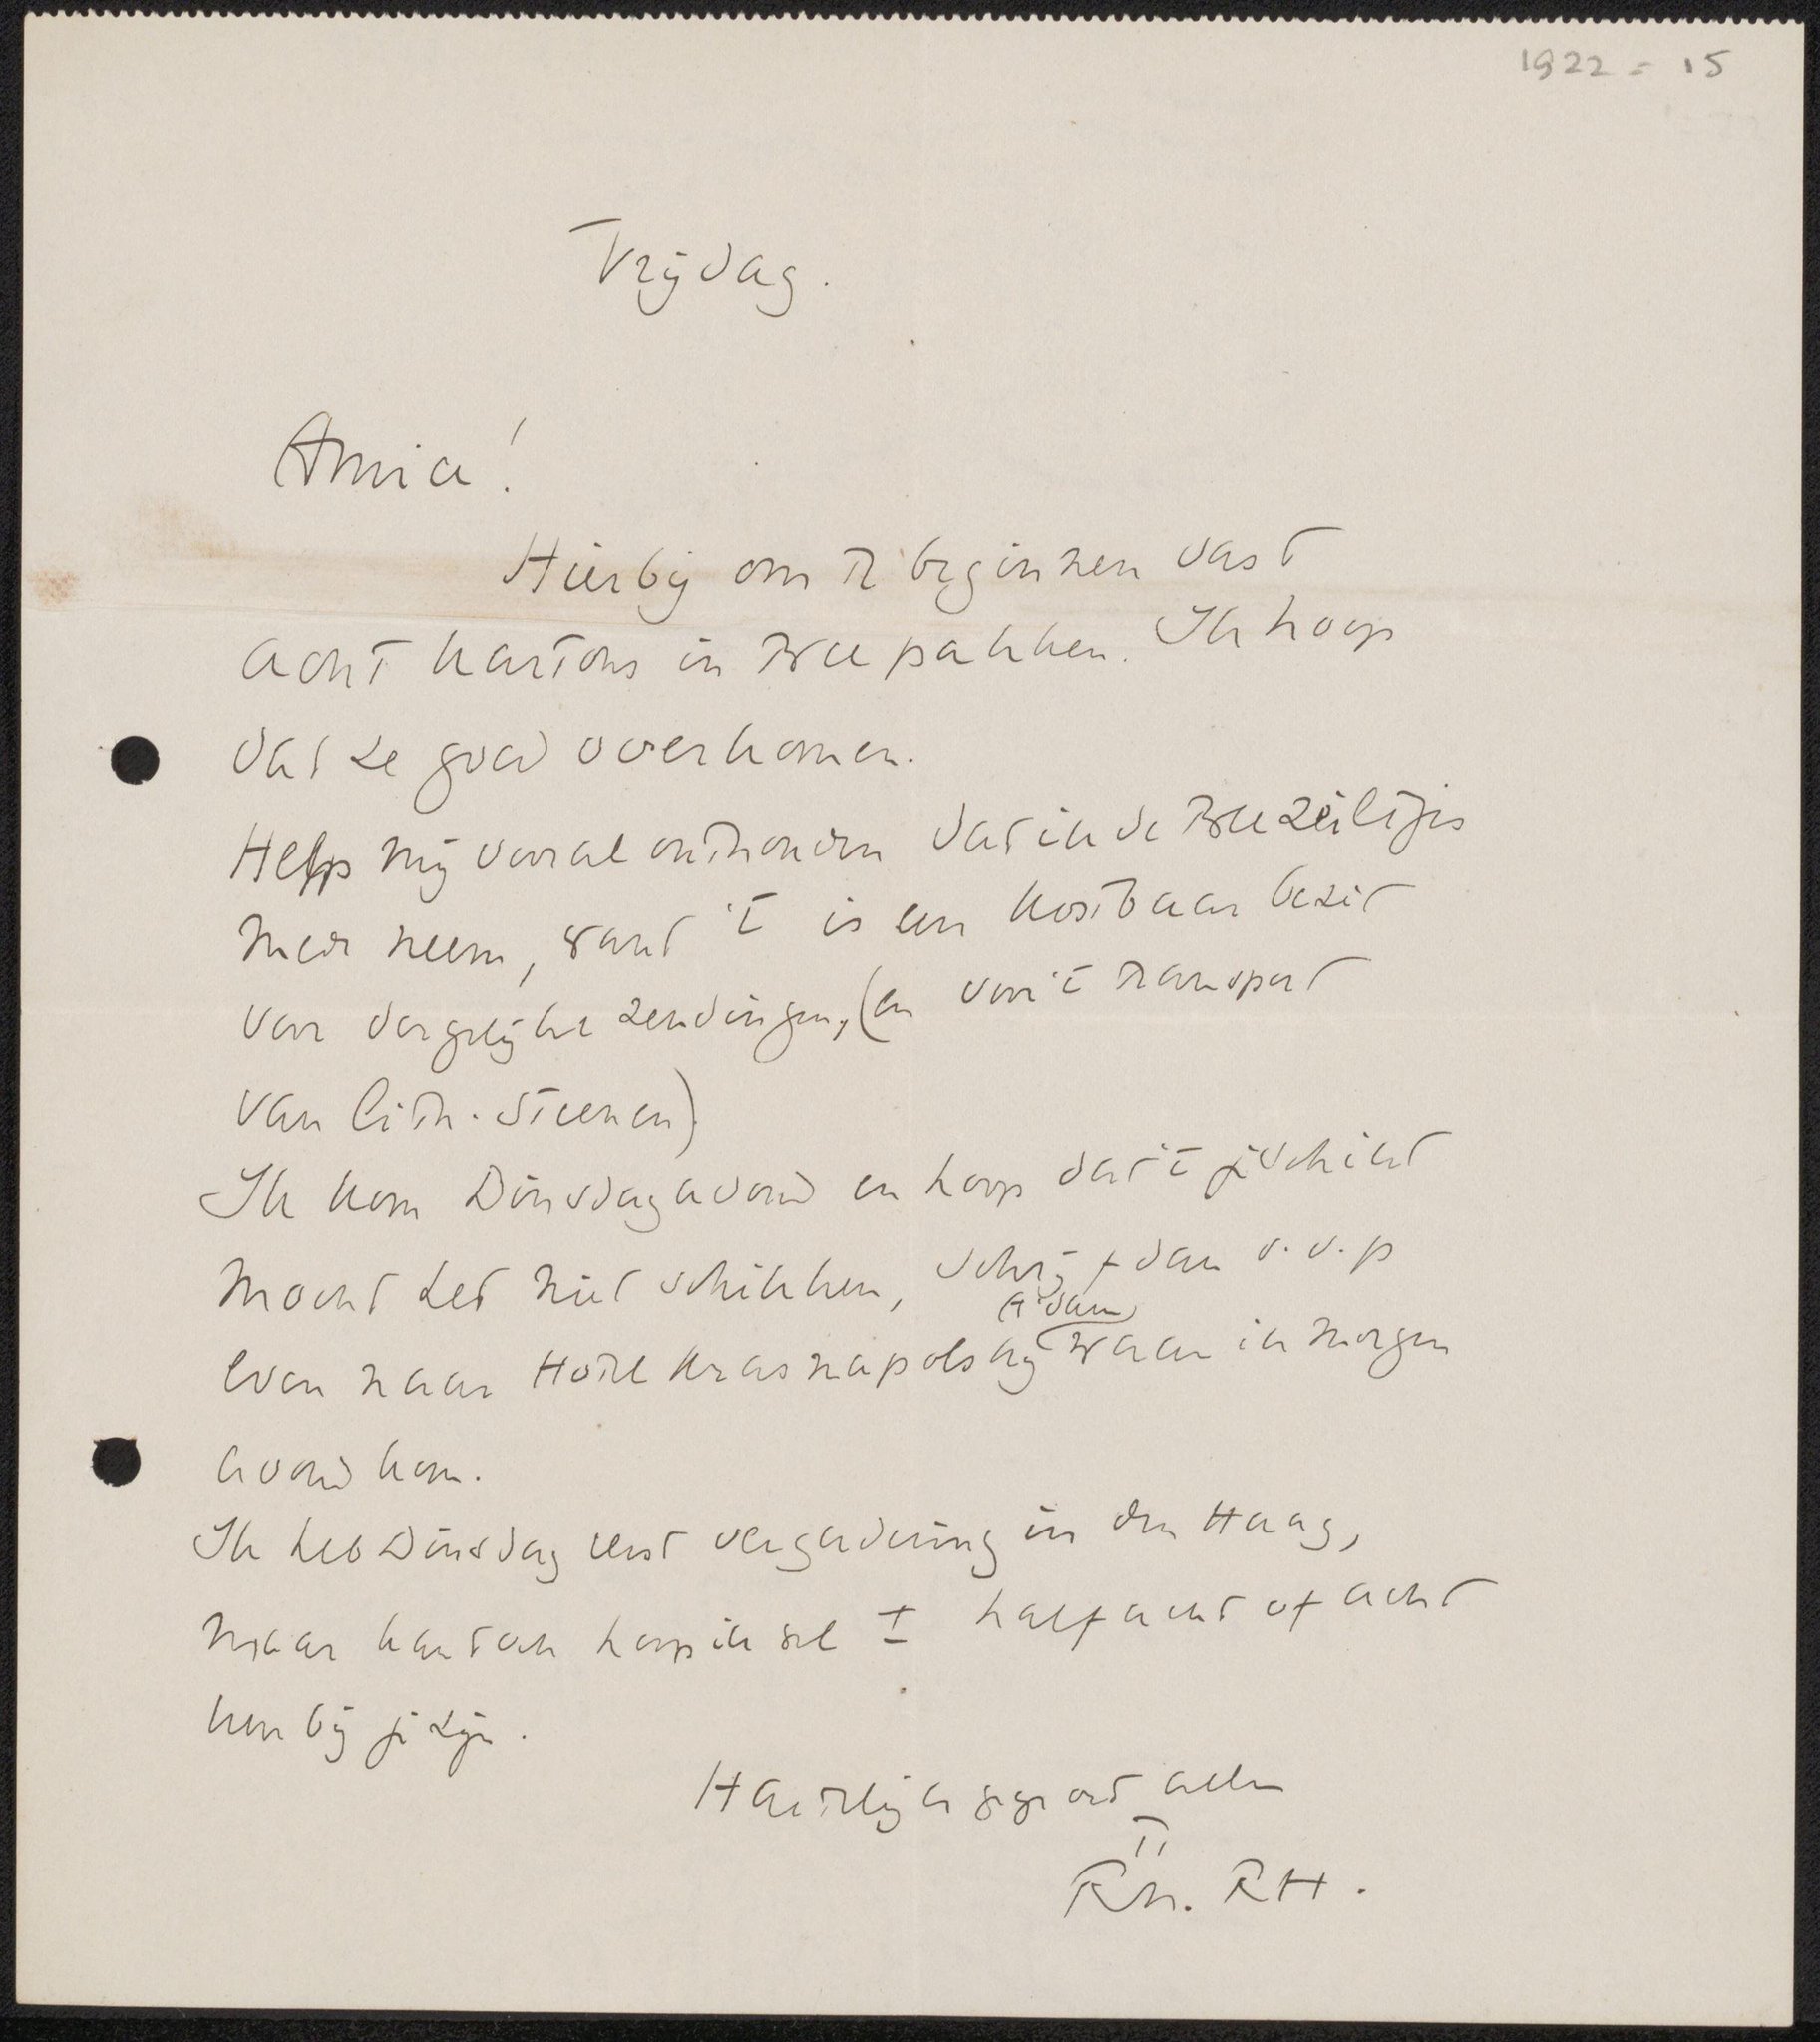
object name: letter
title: Brief aan Willem Bogtman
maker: richard nicolaüs roland holst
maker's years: 1868-1938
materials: ink, paper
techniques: pen, writing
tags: haarlem, willem bogtman, drawing, the graphic arts, money, the hague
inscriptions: watermark